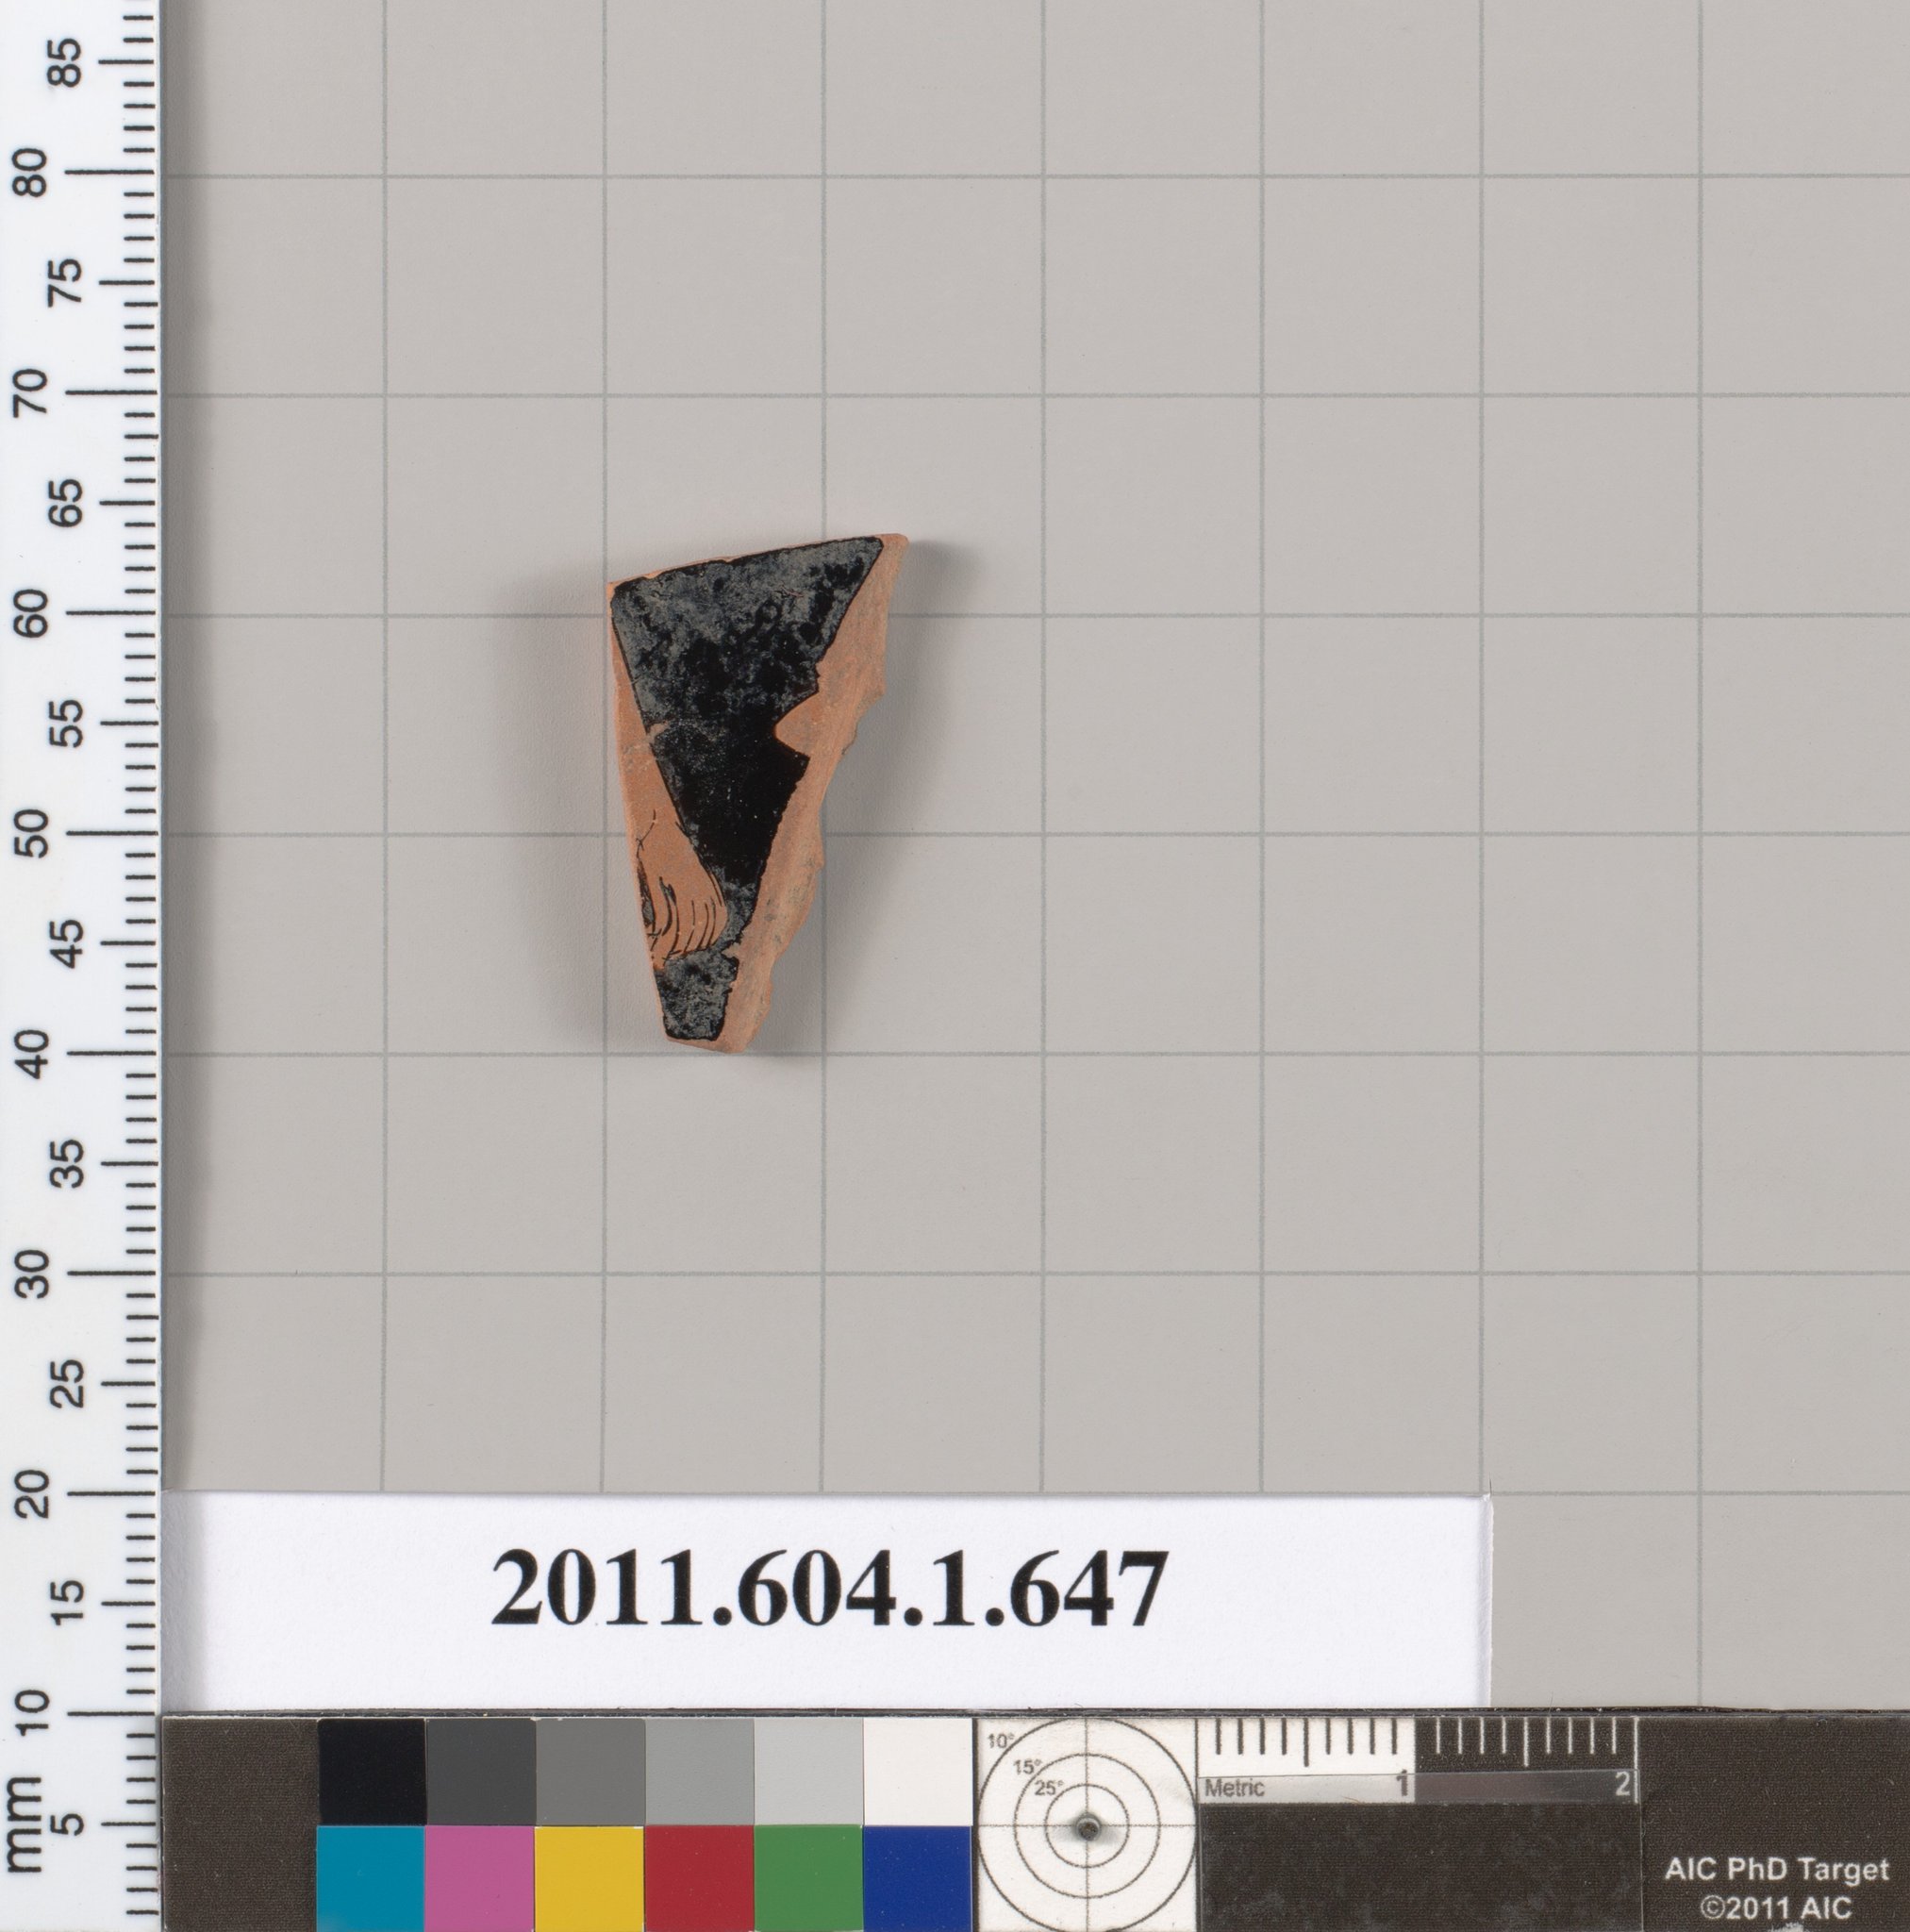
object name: kylix fragment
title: Terracotta fragment of a kylix (drinking cup)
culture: greek, attic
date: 475-451 BCE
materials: terracotta